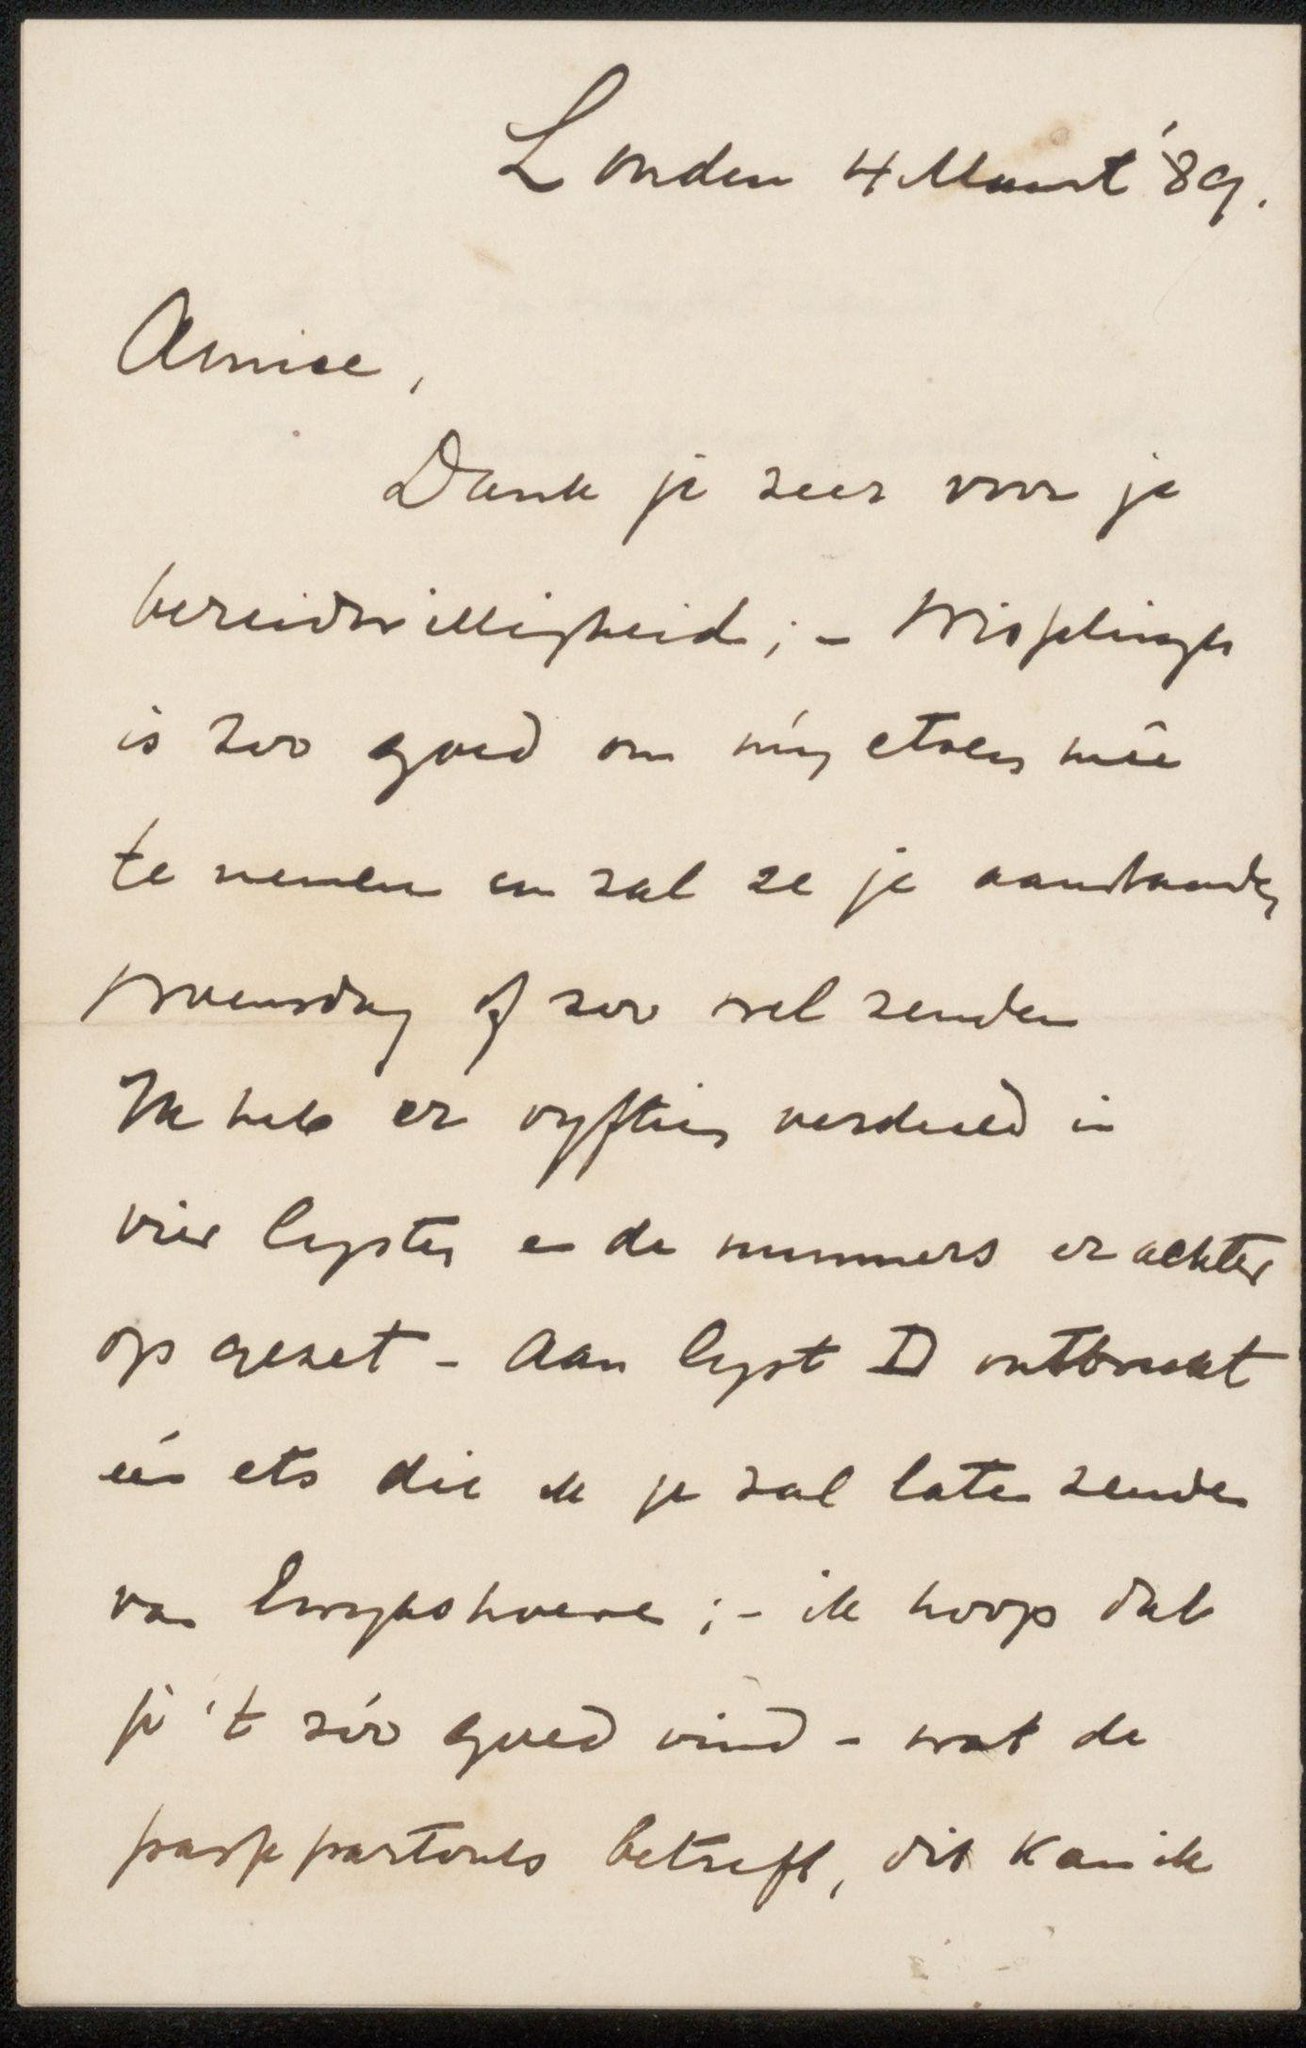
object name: letter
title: Brief aan Philip Zilcken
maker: willem witsen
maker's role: draughtsman, painter, print maker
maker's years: 1860-1923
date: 1889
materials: ink, paper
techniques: pen, writing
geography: london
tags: elbert jan van wisselingh, painter, draughtsman, philip zilcken, the graphic arts, exhibition ~ art, money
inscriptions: collector's mark: ‘RPK’, watermark